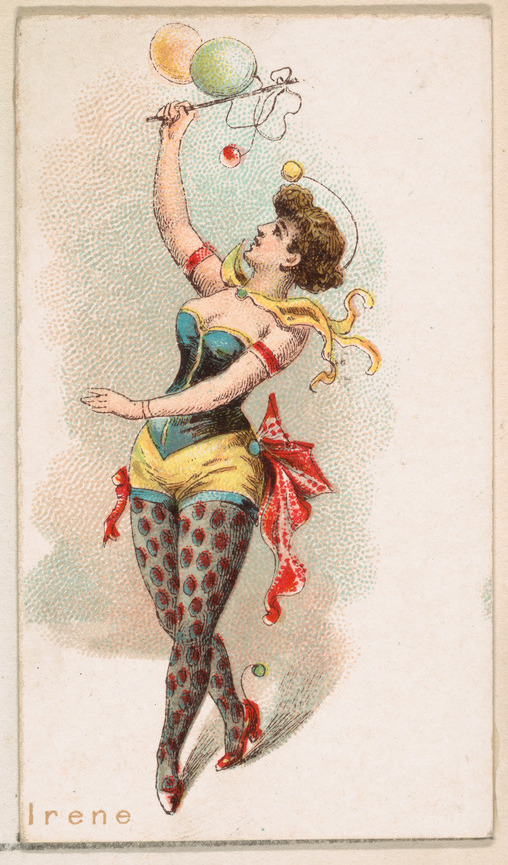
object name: print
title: Irene, from the Ballet Queens series (N182) issued by Wm. S. Kimball & Co.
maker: william s. kimball & company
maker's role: publisher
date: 1889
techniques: color lithograph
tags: women,dancers